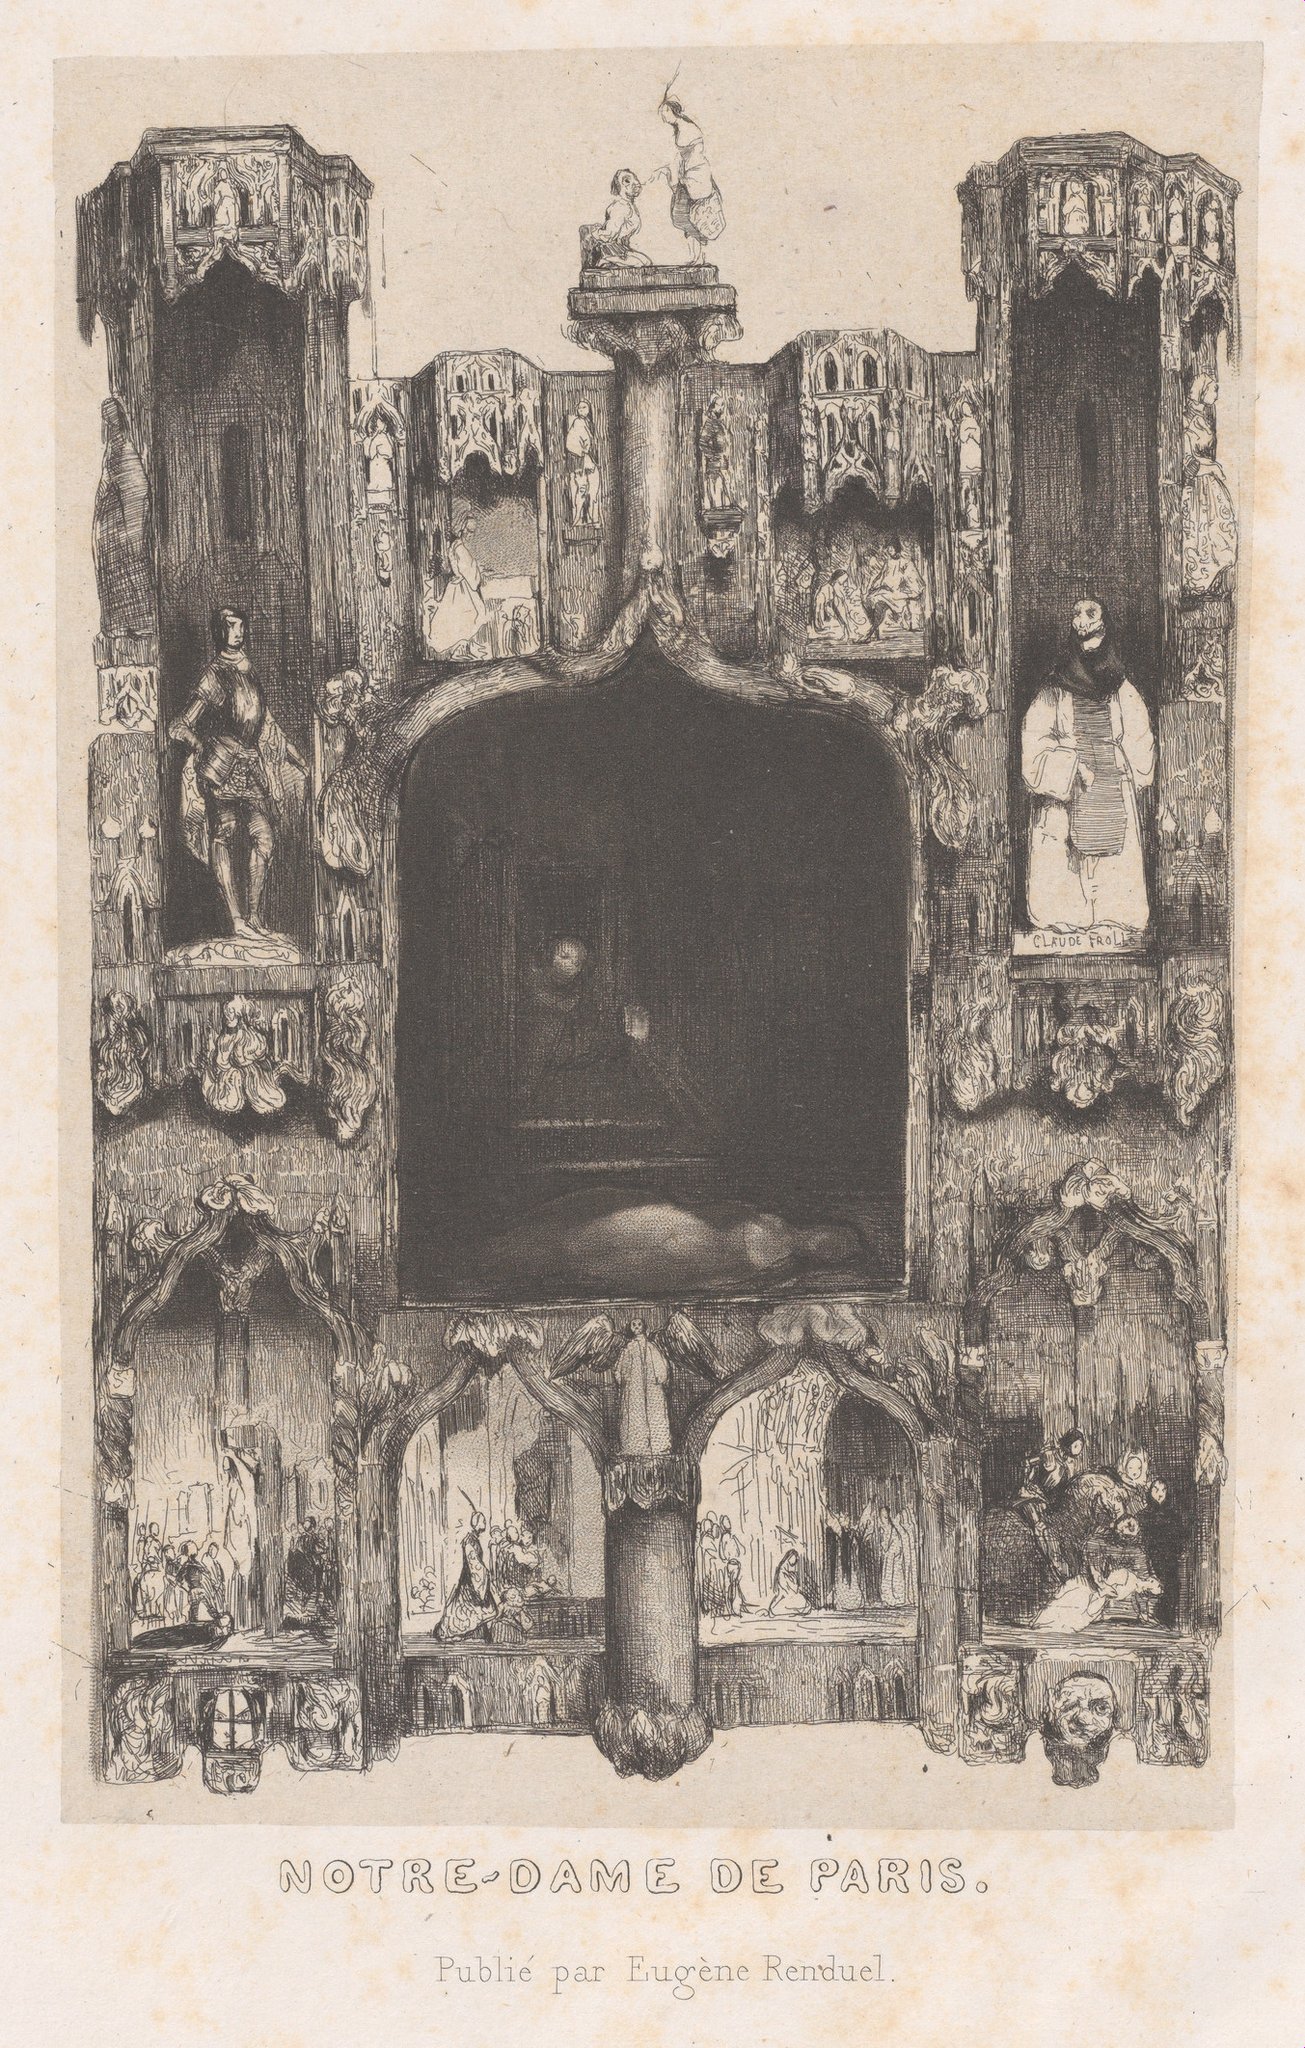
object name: print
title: Notre-Dame de Paris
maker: célestin nanteuil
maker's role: artist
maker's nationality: french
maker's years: 1813-1873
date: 1832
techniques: etching